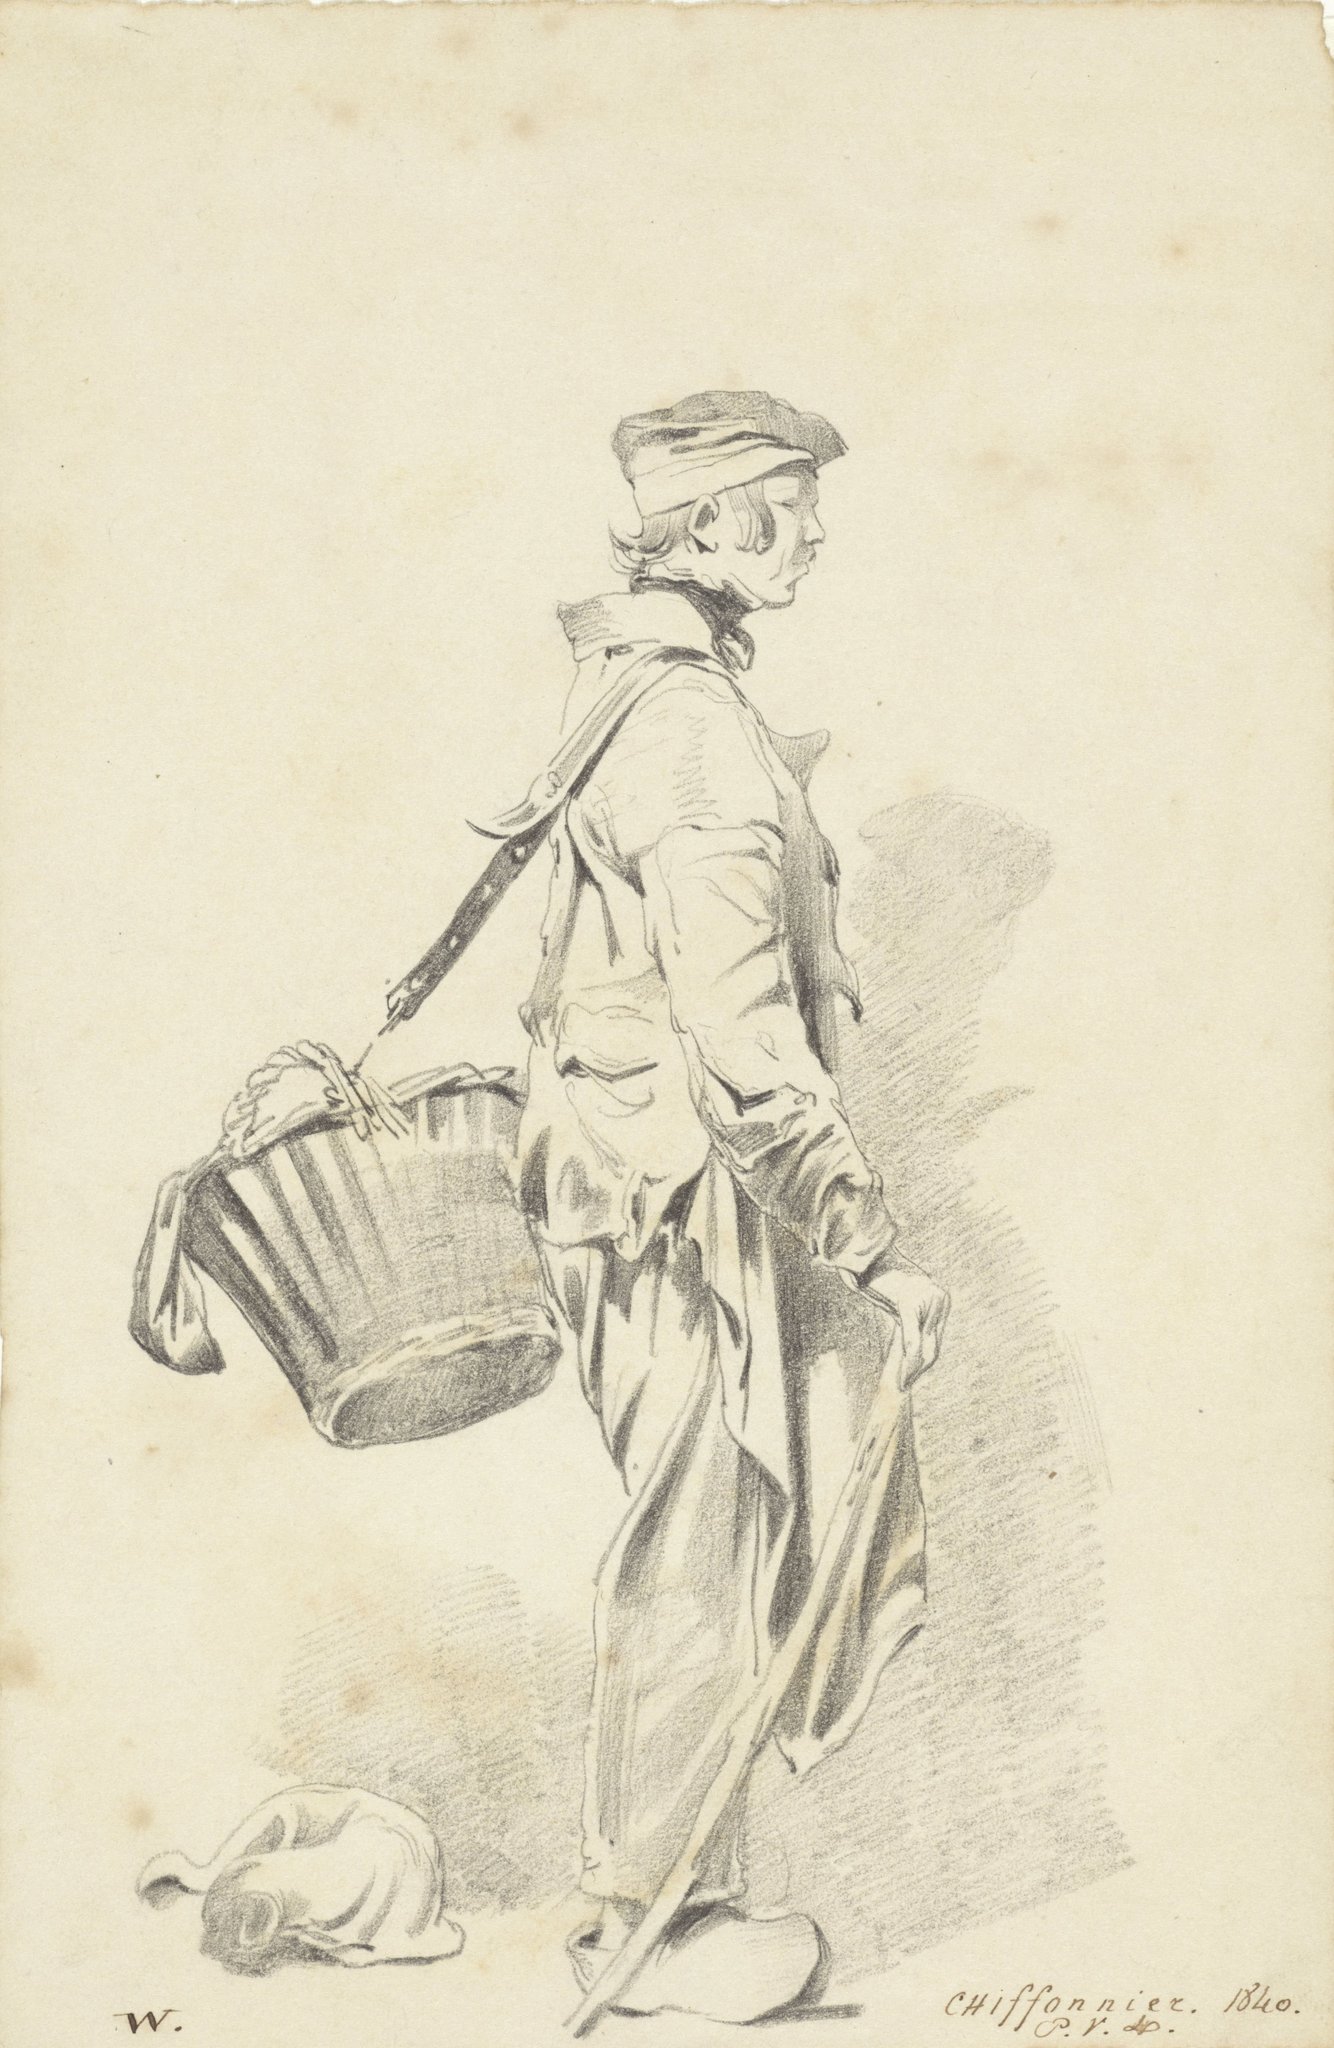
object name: drawing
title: Voddenboer, staand naar rechts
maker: pieter van loon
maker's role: draughtsman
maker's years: 1801-1873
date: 1840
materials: paper, pencil